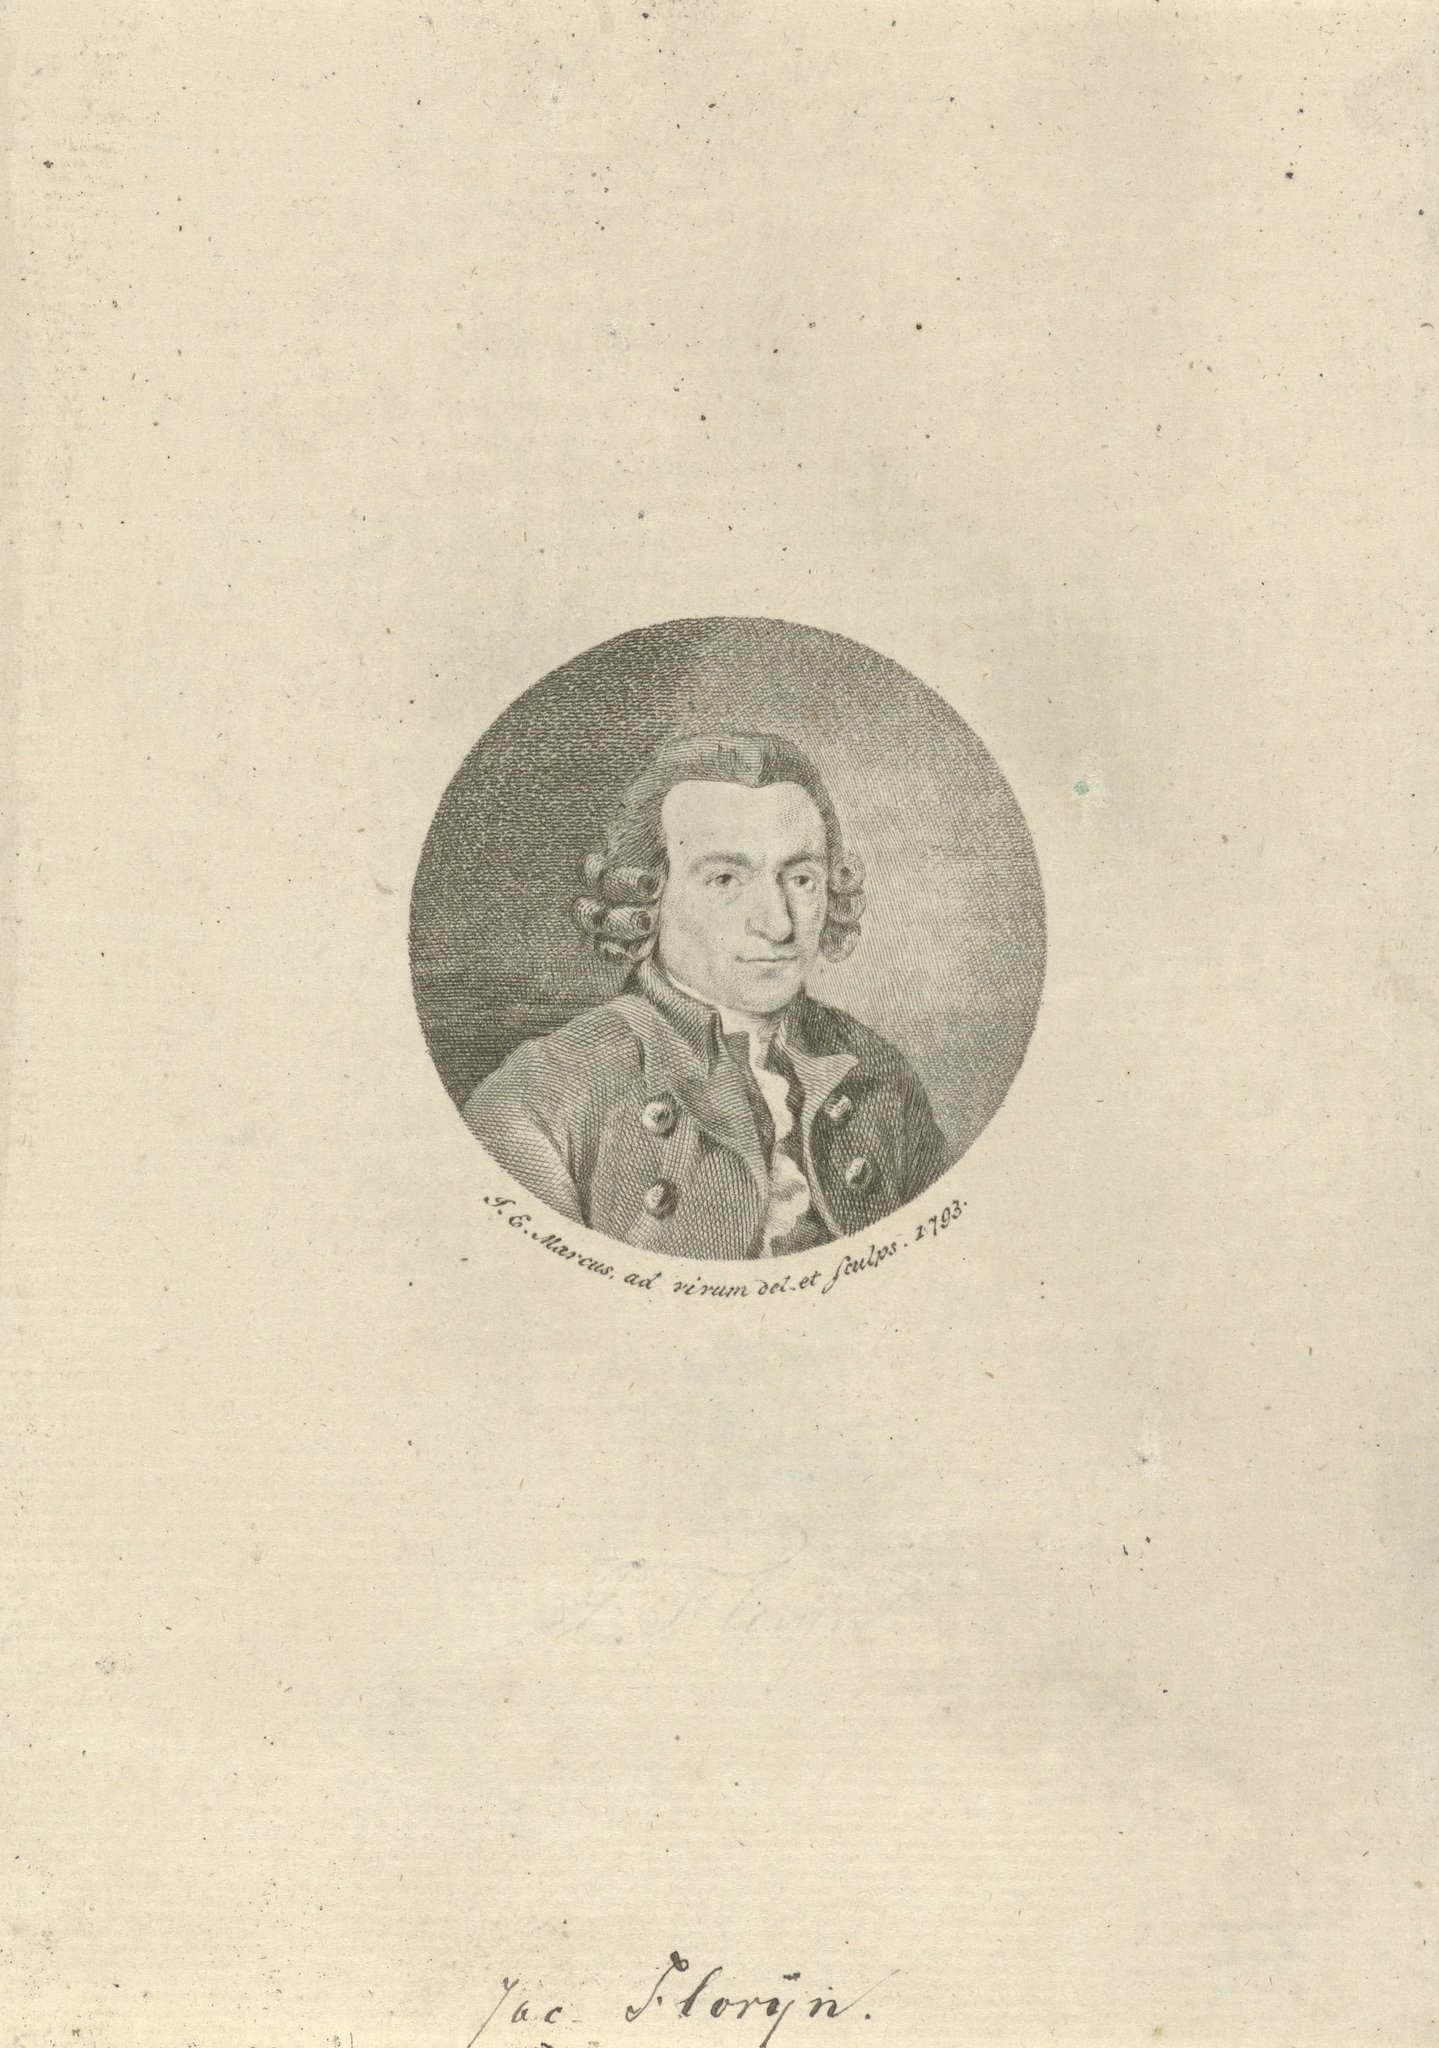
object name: print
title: Portret van Evert Florijn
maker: jacob ernst marcus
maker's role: draughtsman, print maker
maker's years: 1774-1826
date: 1793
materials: paper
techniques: etching, pen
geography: amsterdam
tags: wiskundige, evert florijn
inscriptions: collector's mark: Lugt 2228, name: ‘Jac. Florijn’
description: Prent gebruikt in de titelpagina voor: Evert Florijn, De arithmetica of rekenkunst, op den koophandel toegepast, in volkomen uitgewerkte voorstellen. Amsterdam, erven Wed. Cornelis Stichter, 1798.